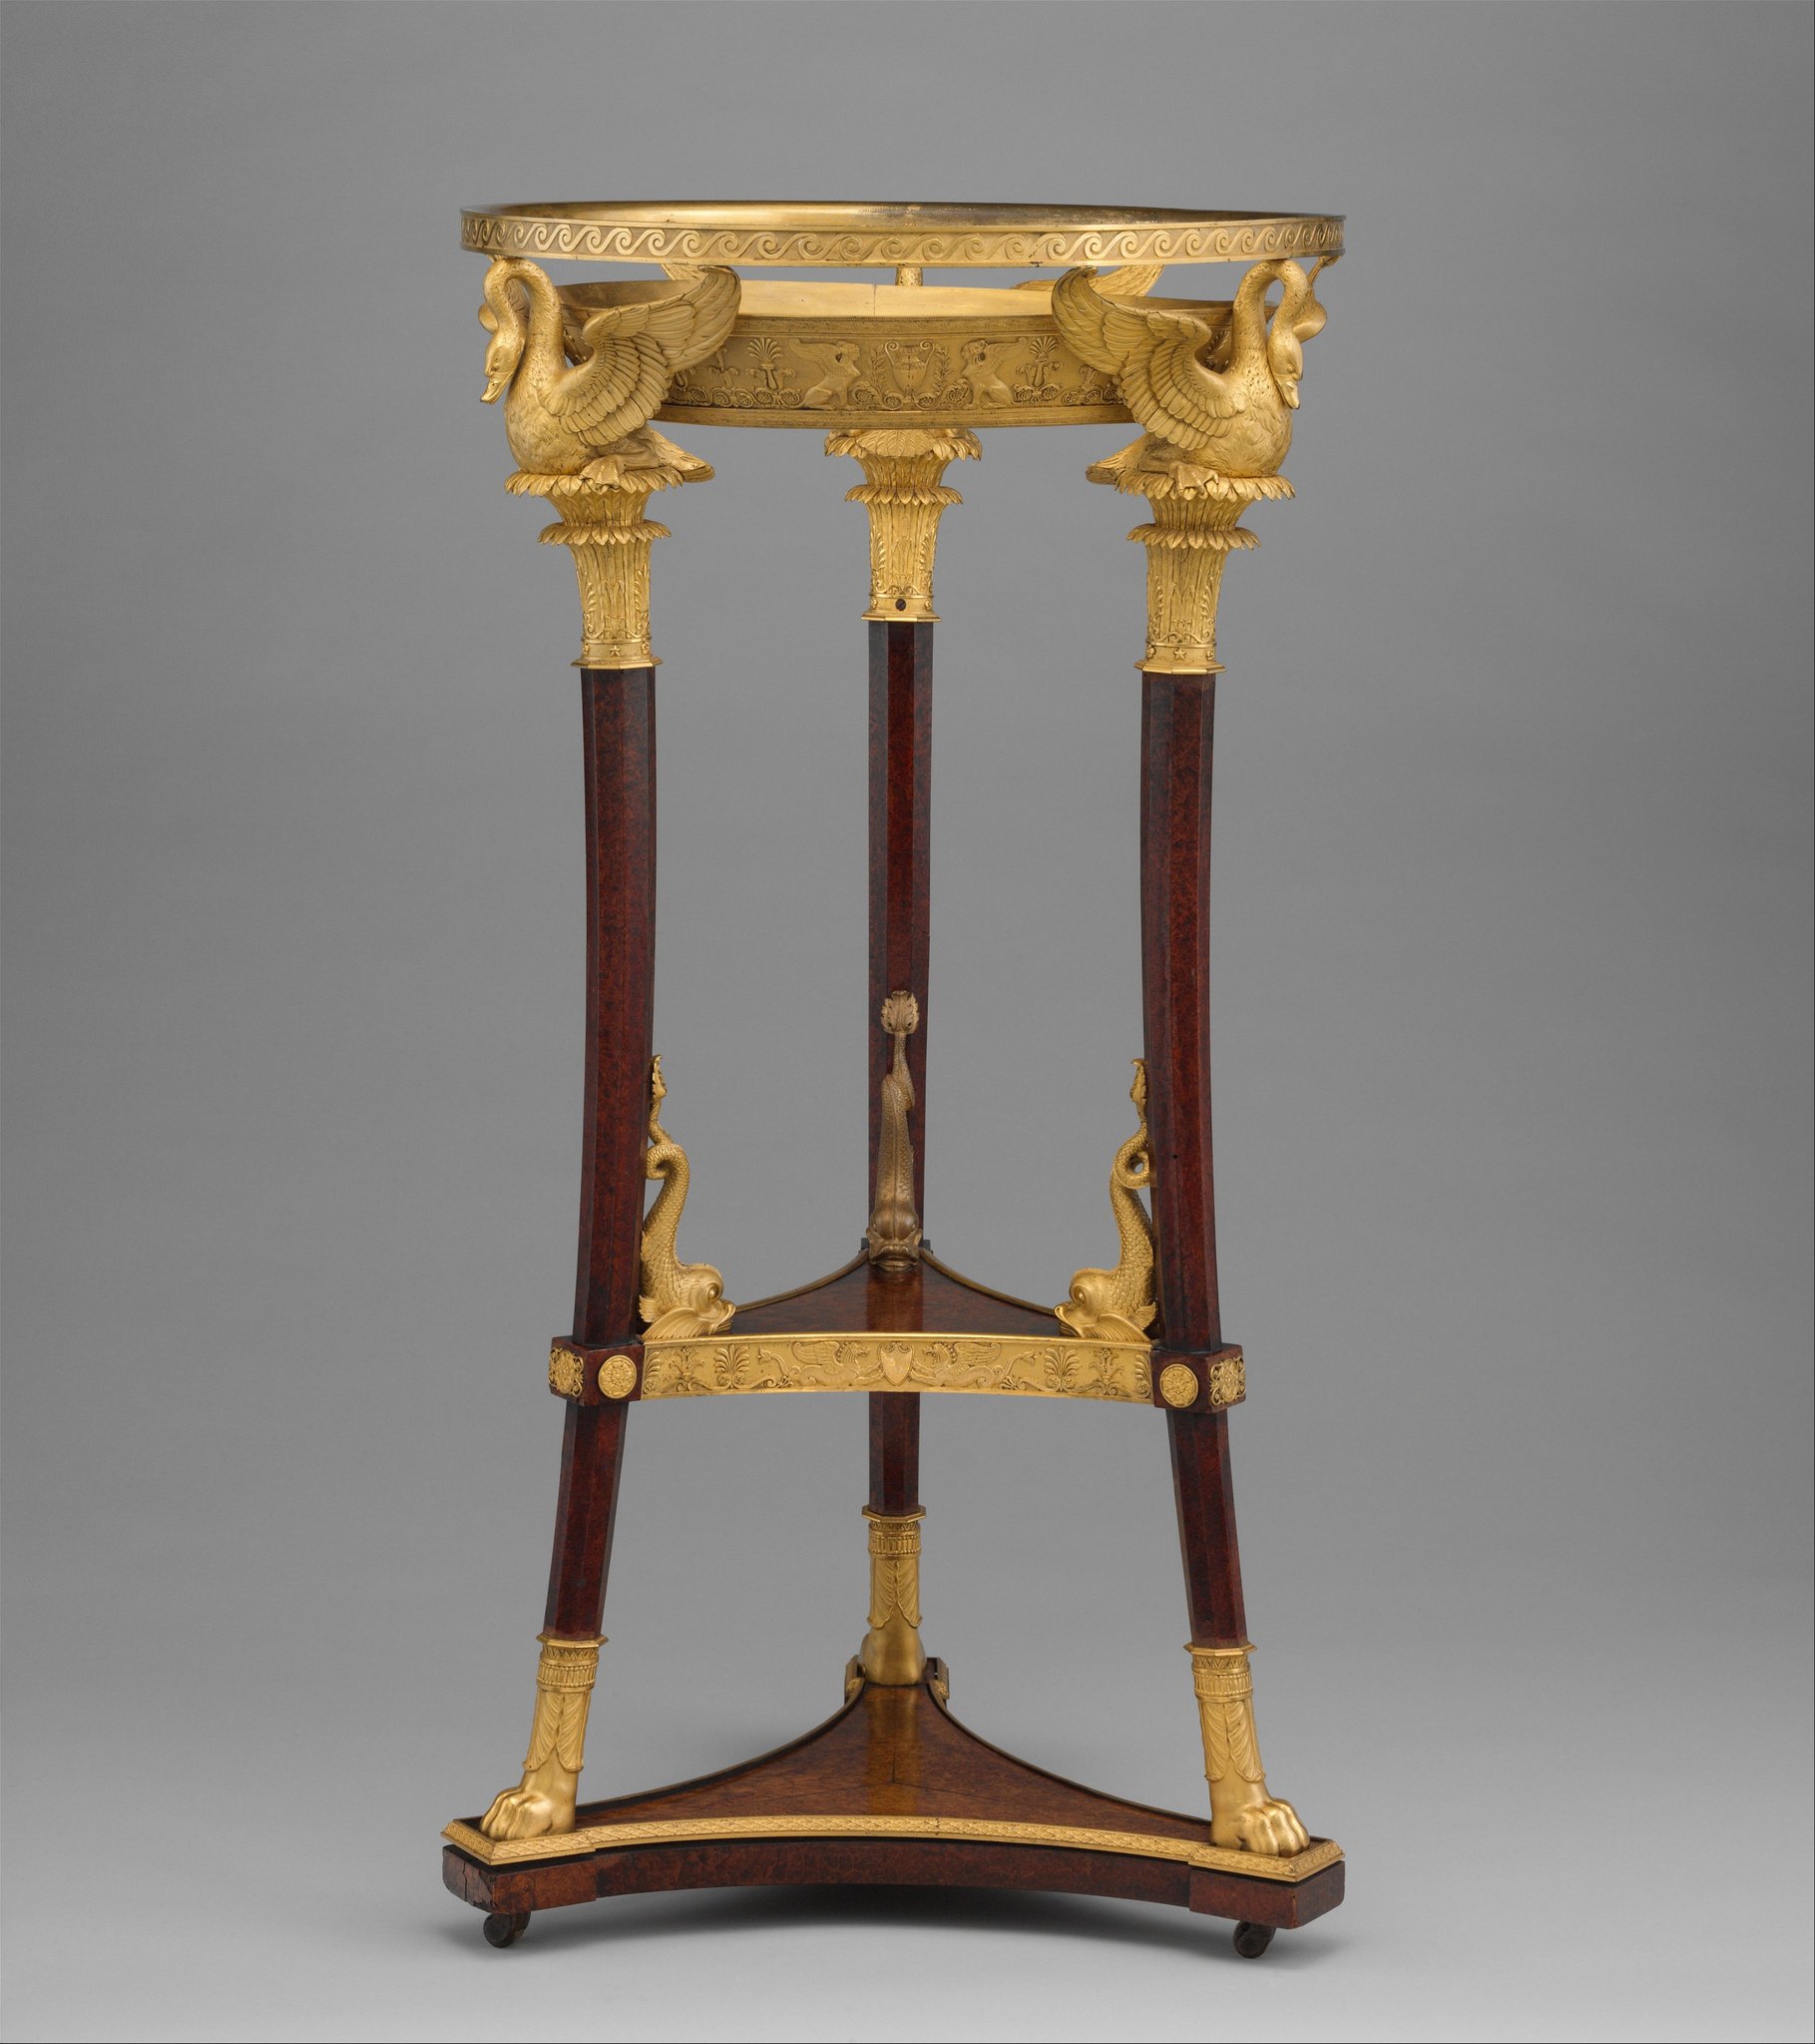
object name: washstand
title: Washstand (athénienne or lavabo)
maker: charles percier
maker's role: designer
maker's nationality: french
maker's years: 1764-1838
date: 1800-1814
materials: gilt bronze, iron, wood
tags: swans,dolphins